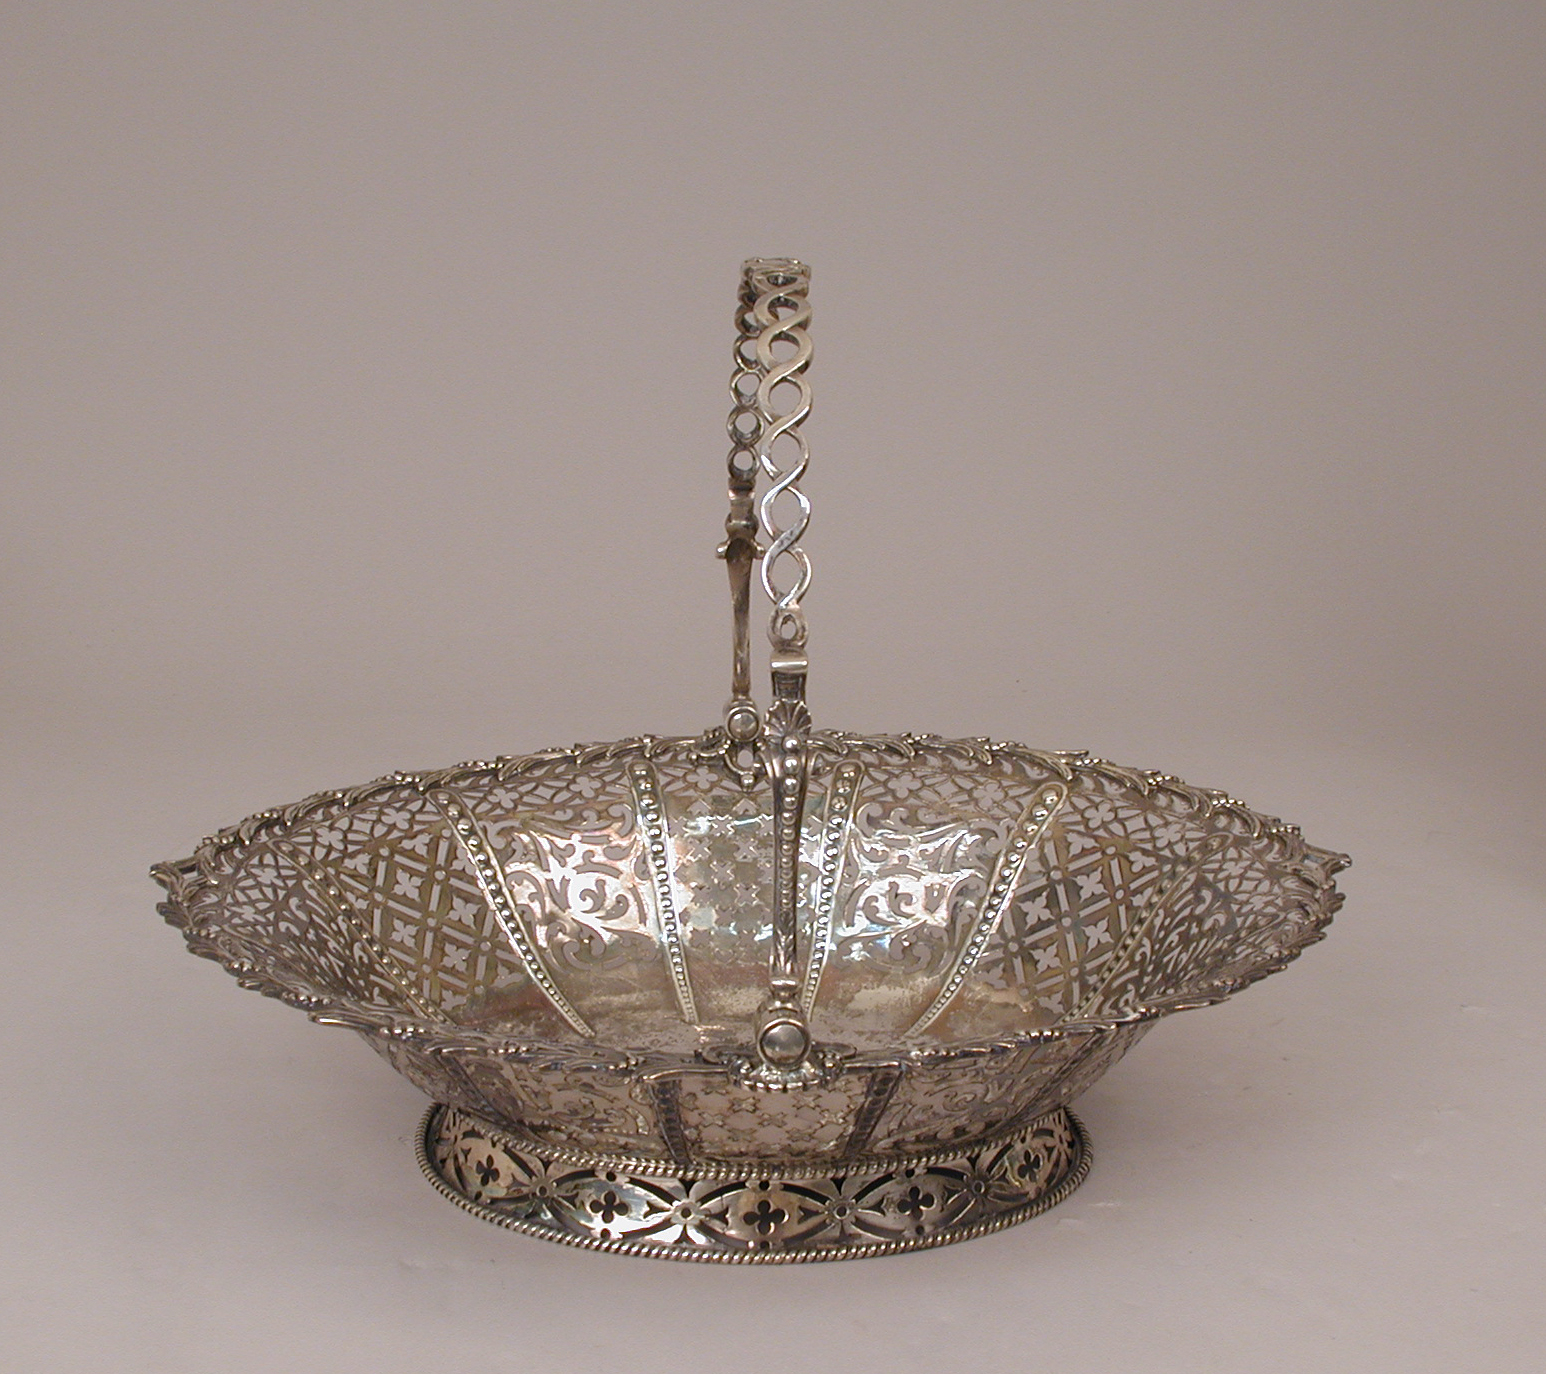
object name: cake basket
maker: william plummer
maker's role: maker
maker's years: 1755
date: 1765-1766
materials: silver